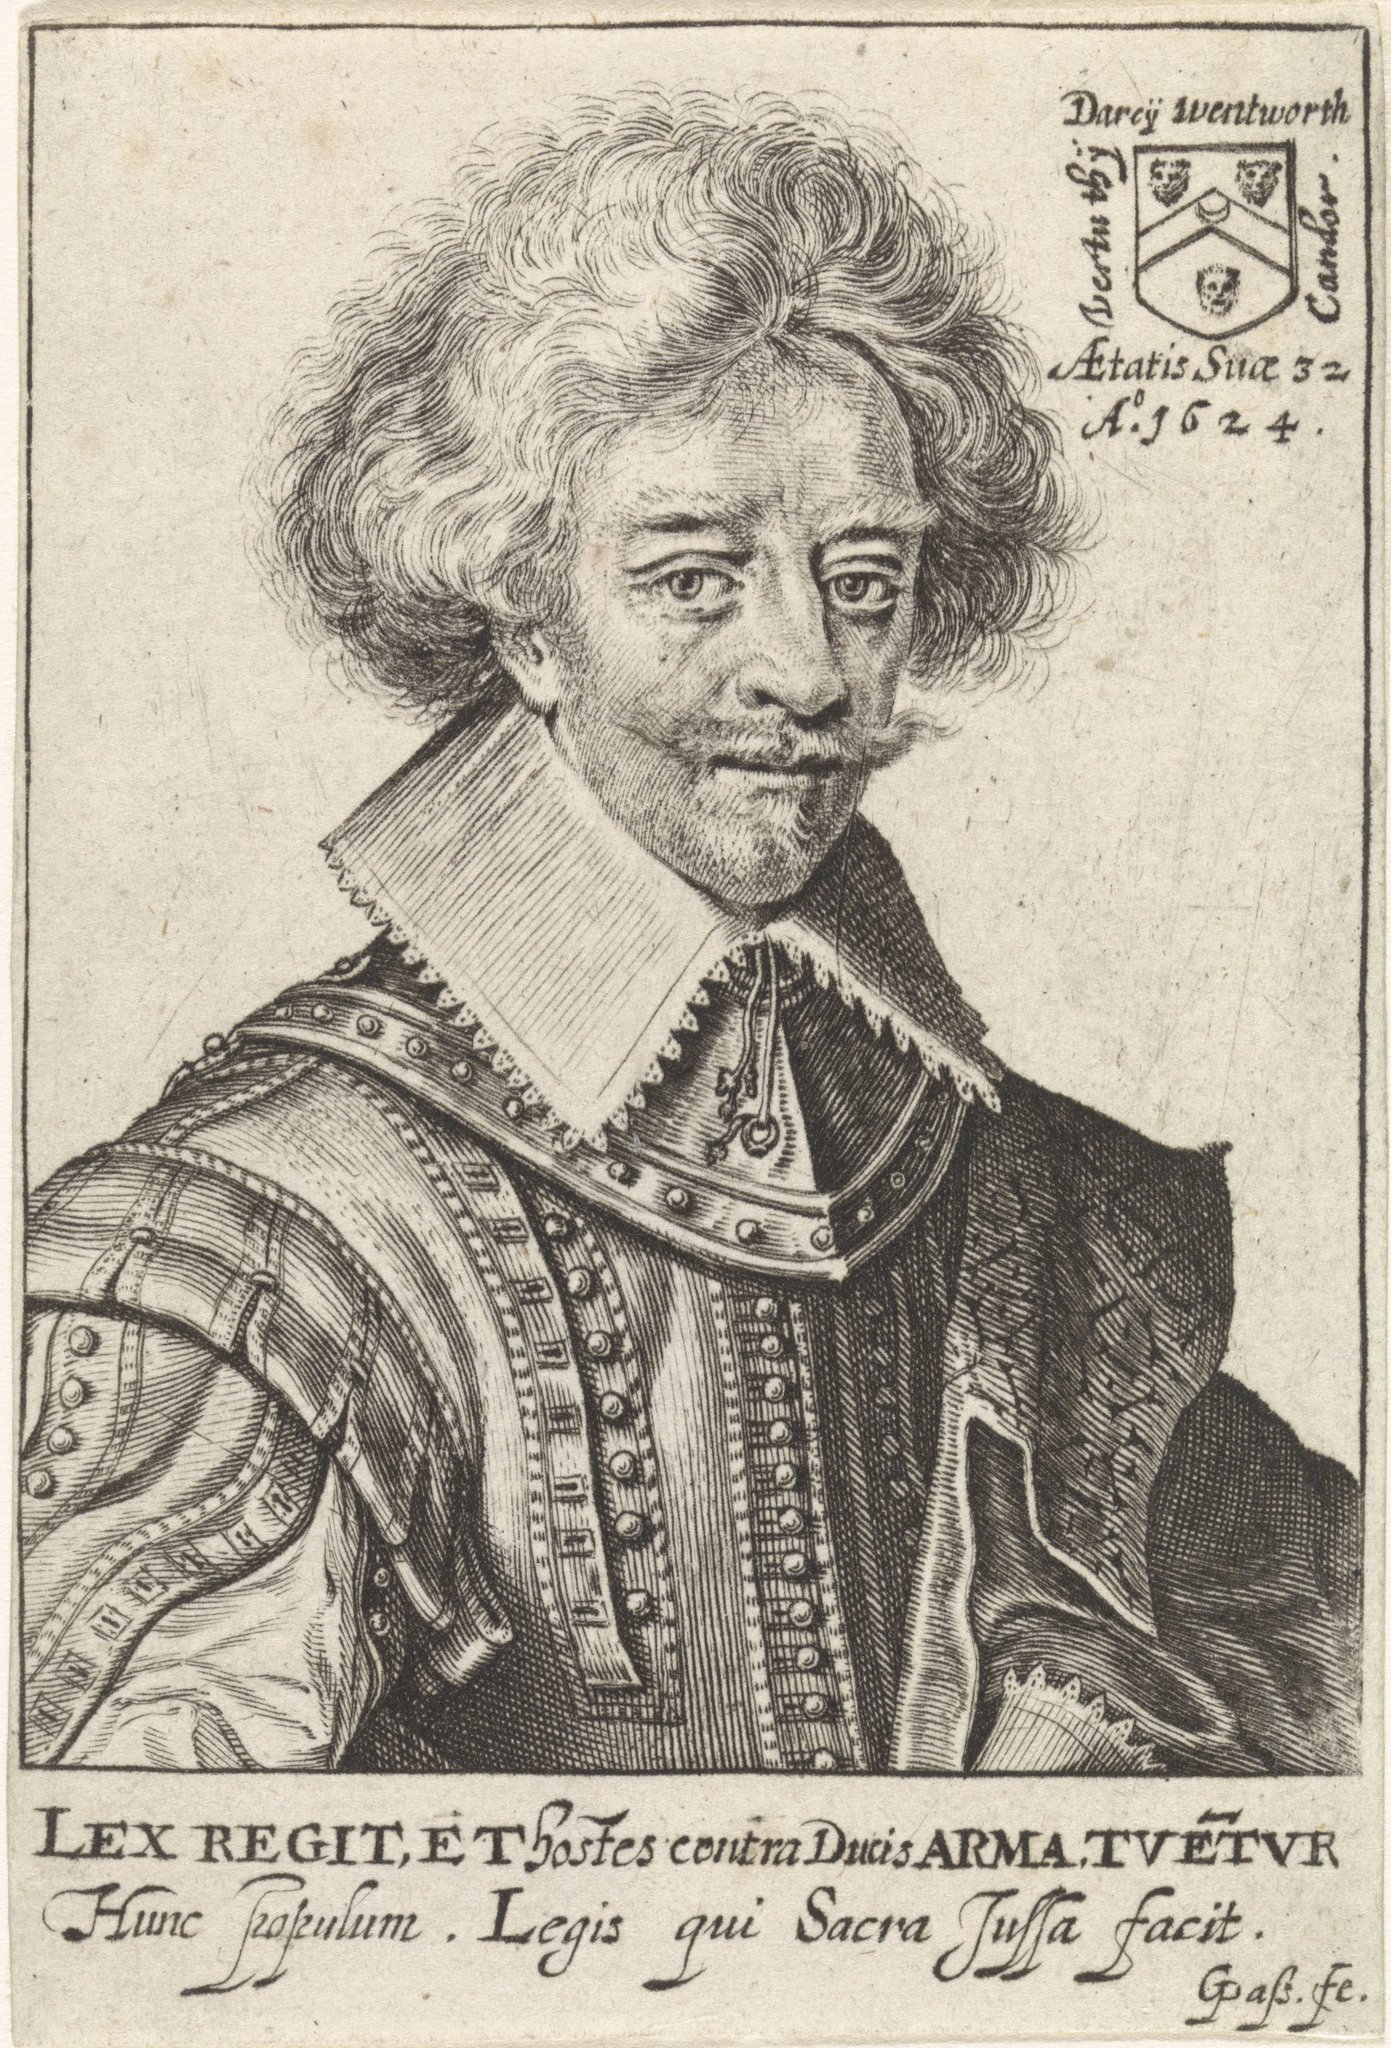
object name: print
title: Portret van Darcy Wentworth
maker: willem van de passe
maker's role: print maker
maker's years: 1597-1637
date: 1624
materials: paper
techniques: engraving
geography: london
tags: darcy wentworth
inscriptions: collector's mark: Lugt 2760, collector's mark: Lugt 2228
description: Portret van Darcy Wentworth, op 32-jarige leeftijd. Rechtsboven zijn wapenschild en een motto in het Latijn. In de marge een tweeregelig lofdicht in het Latijn.